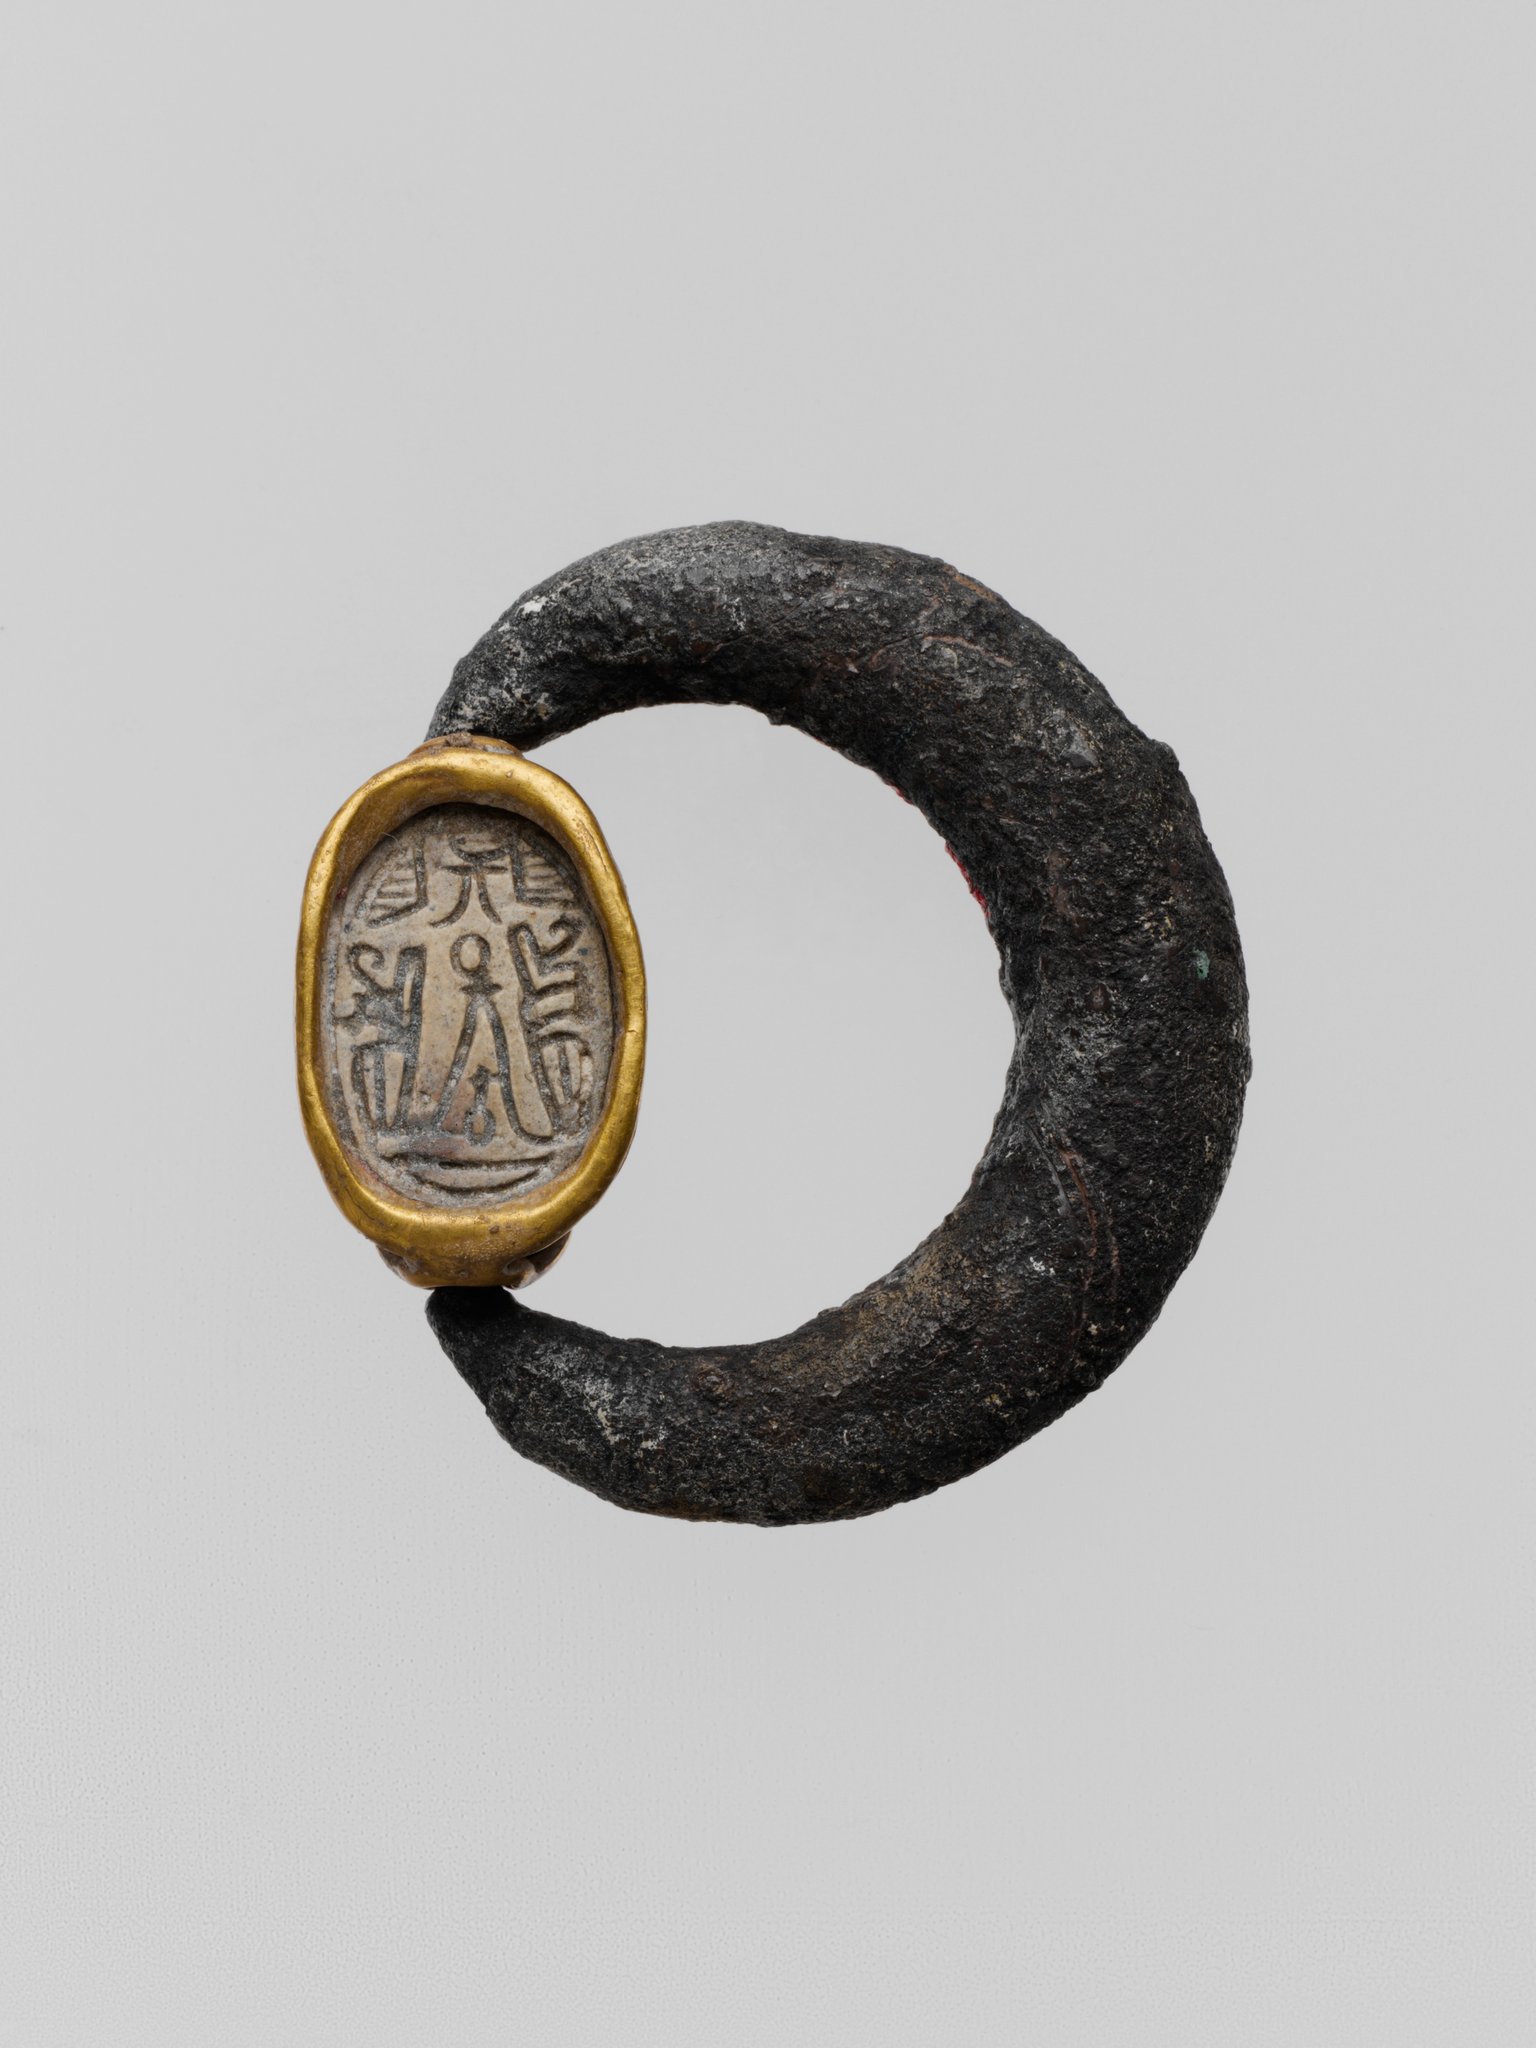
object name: ring with scarab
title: Silver swivel ring with glazed steatite scarab in a gold setting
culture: phoenician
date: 800-601 BCE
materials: gold, silver, stone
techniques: glazing